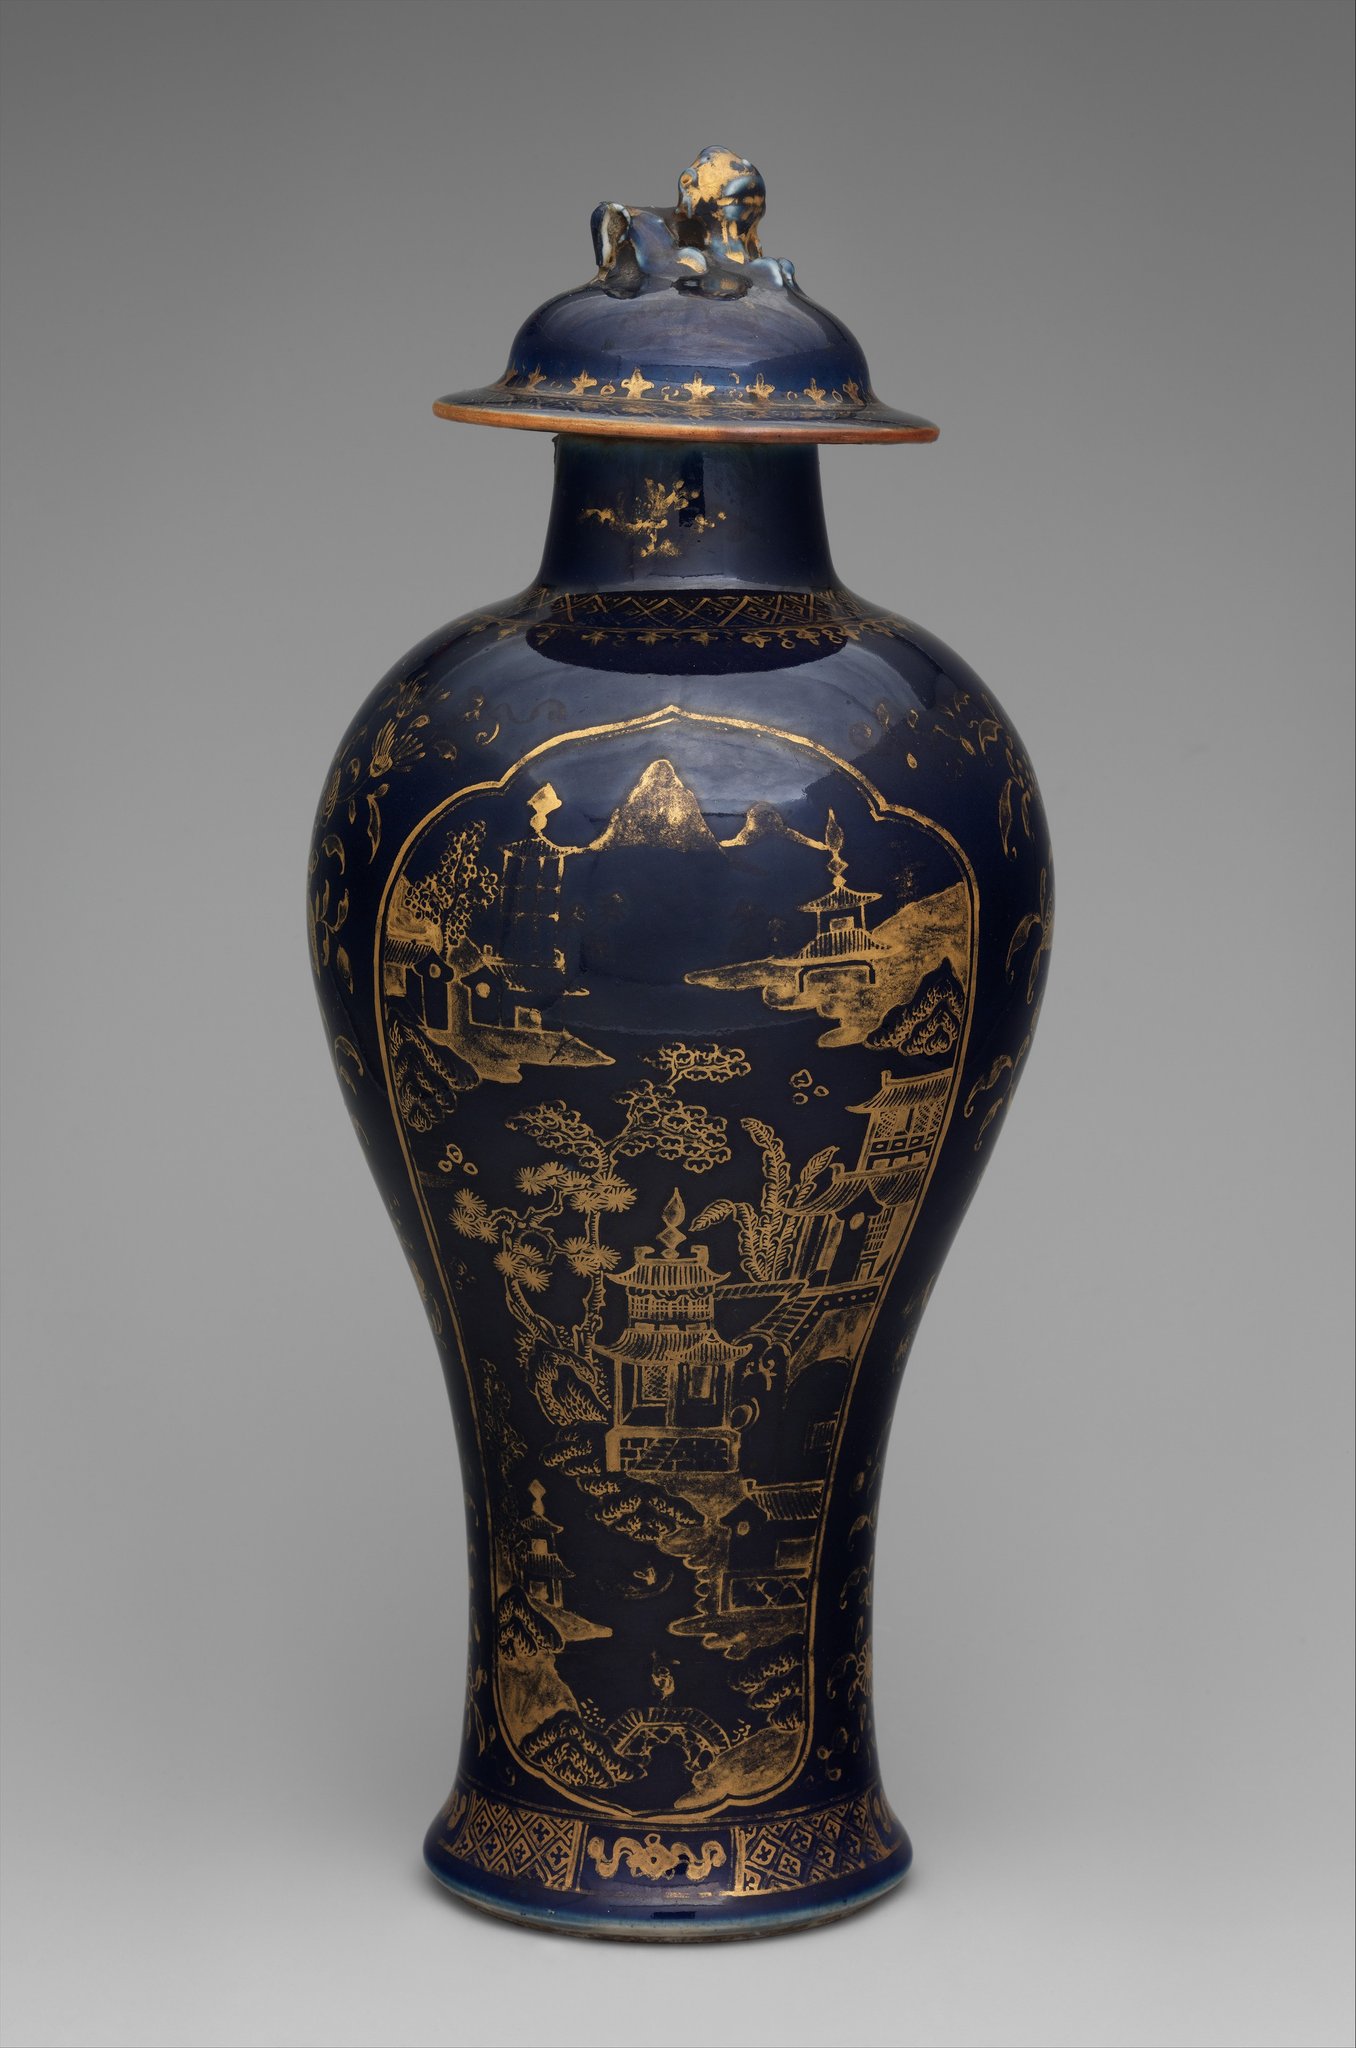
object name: vase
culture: chinese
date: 1770-1795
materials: porcelain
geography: china